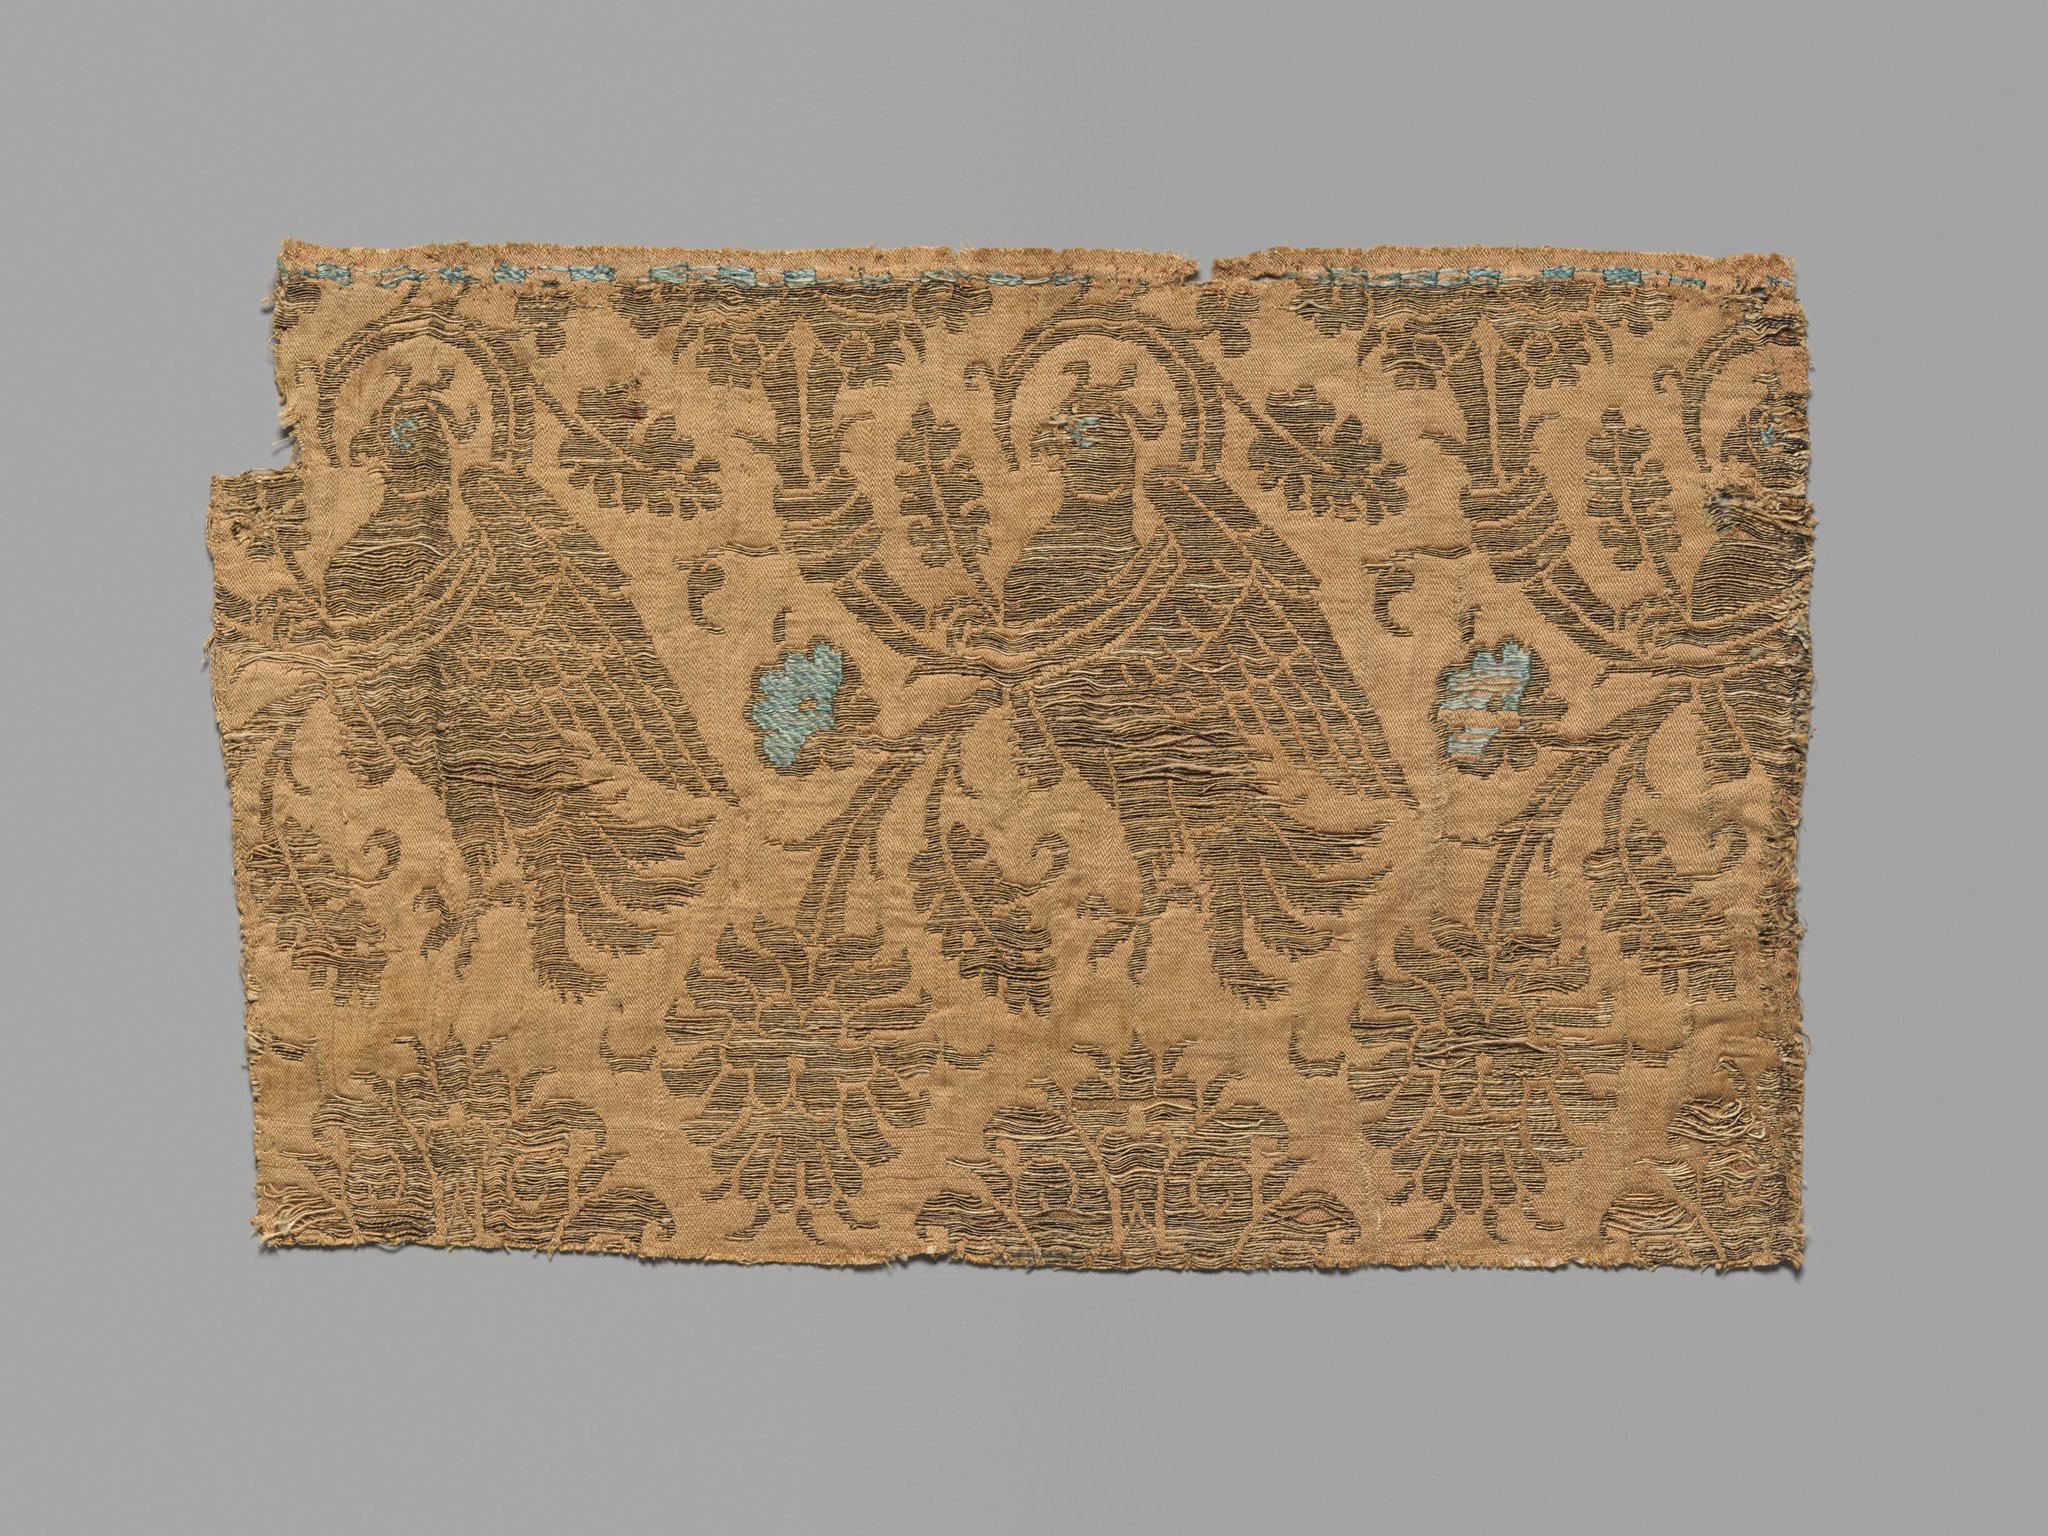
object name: textile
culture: italian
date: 1301-1400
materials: metal thread, silk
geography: italy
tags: birds